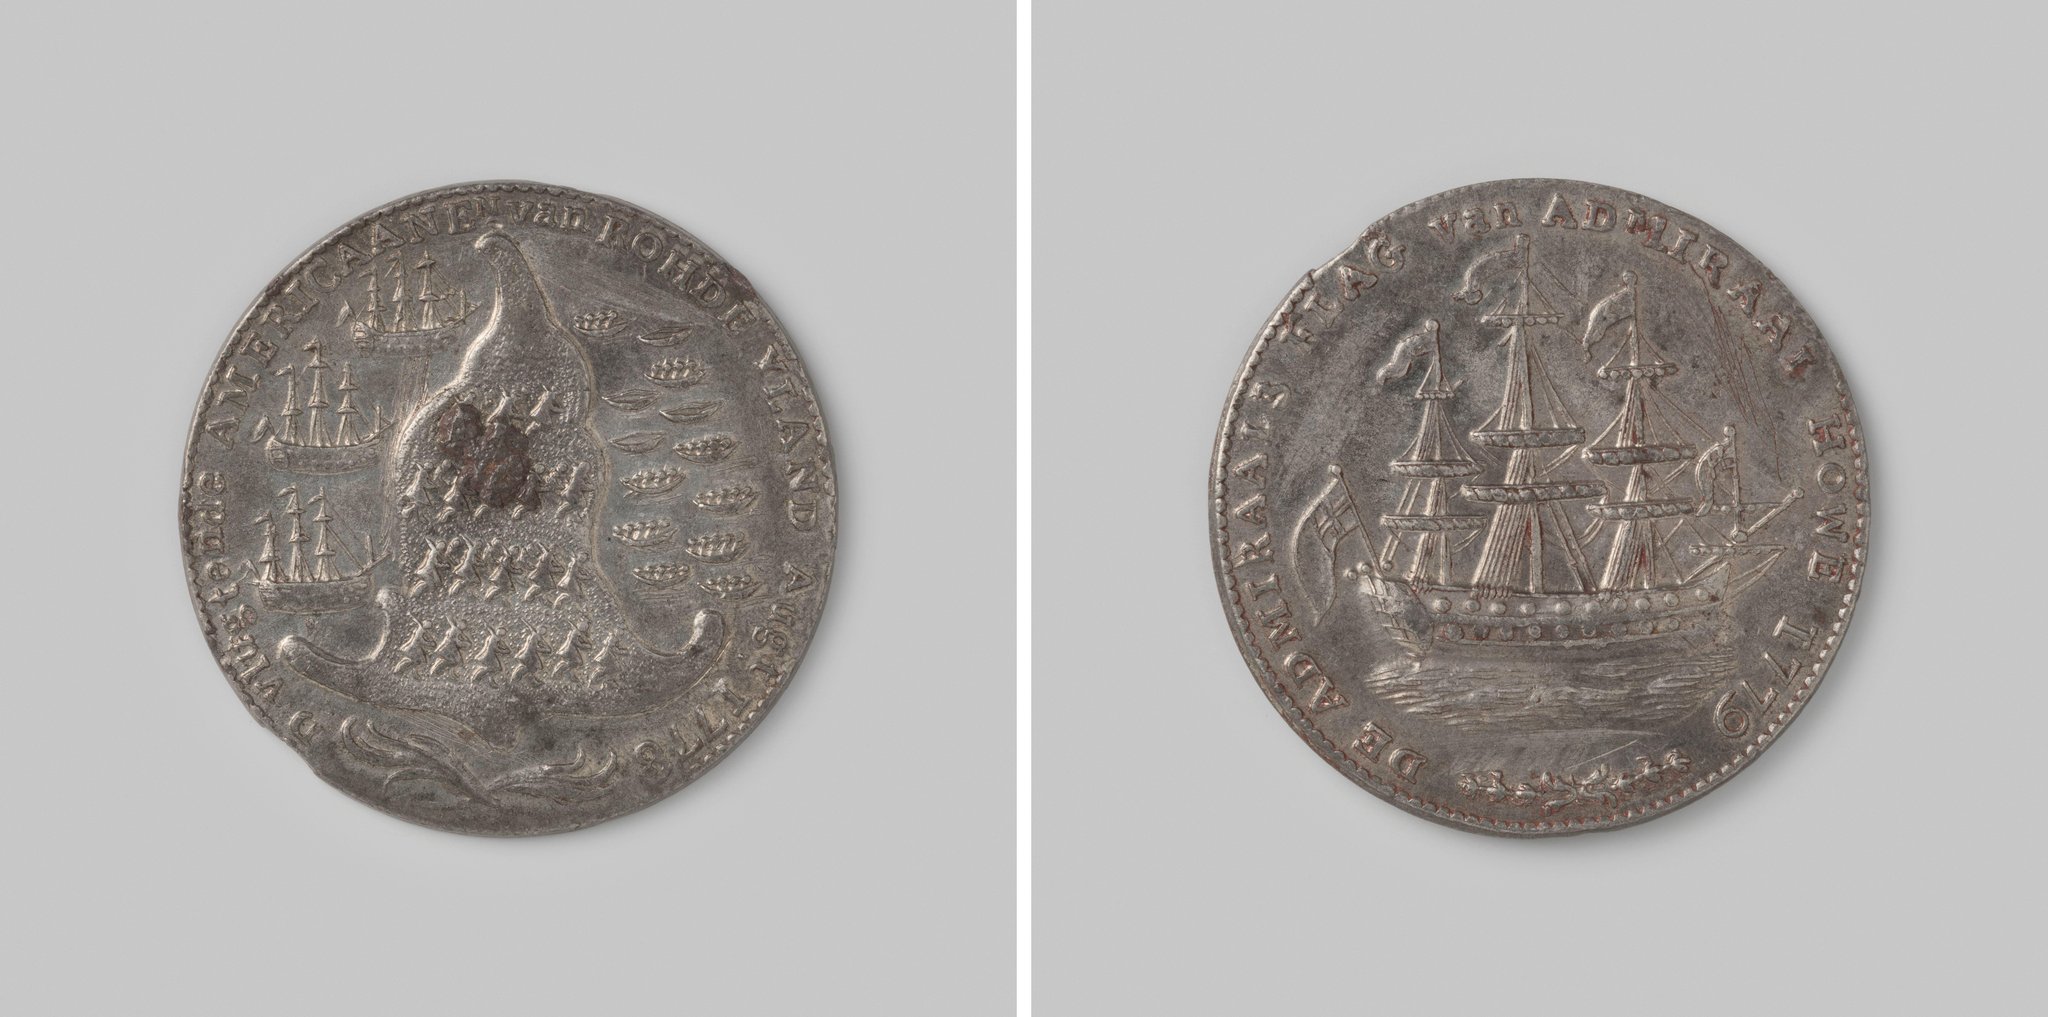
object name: history medal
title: Overwinning van Admiraal Howe op de Amerikanen op Rhode Island 1779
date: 1779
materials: silver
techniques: pressing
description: Zilveren penning, op de voorzijde de plattegrond van Rhode Island vol vluchtende soldaten, links drie oorlogschepen en rechts dertien sloepem, met omschift, op de keerzijde een driemaster met omschrift.